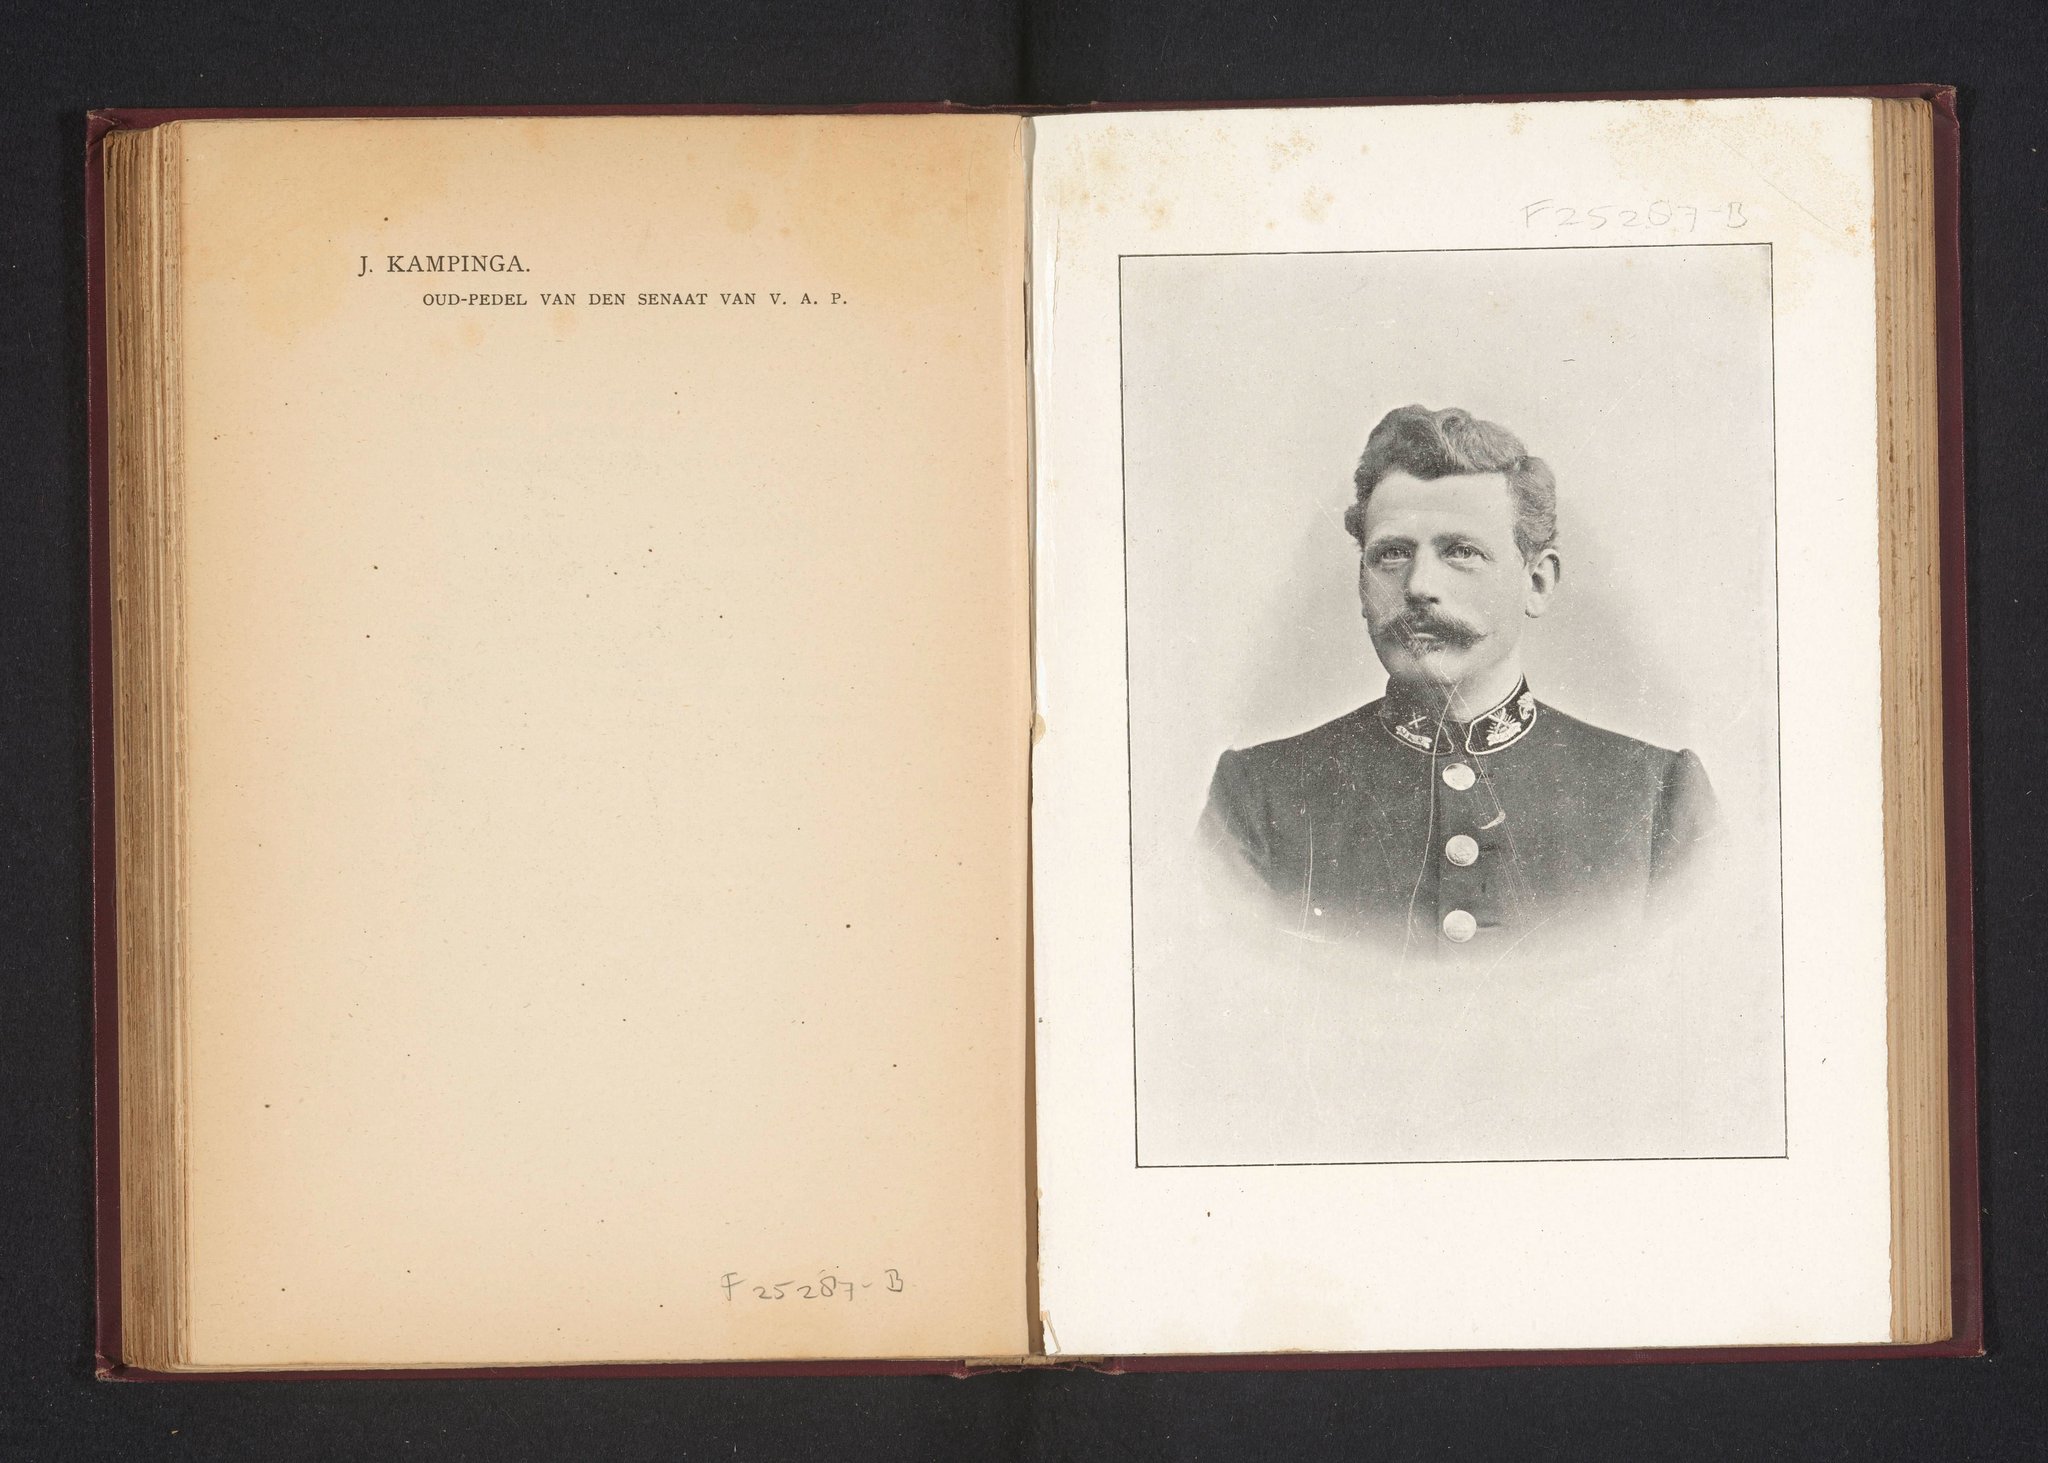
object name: page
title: J. Kampinga. Oud-pedel van den Senaat van V.A.P.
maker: Anonymous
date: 1894-1899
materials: paper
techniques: autotype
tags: beadle, historical persons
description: Prent op derde ongenummerde pagina na pagina 150.